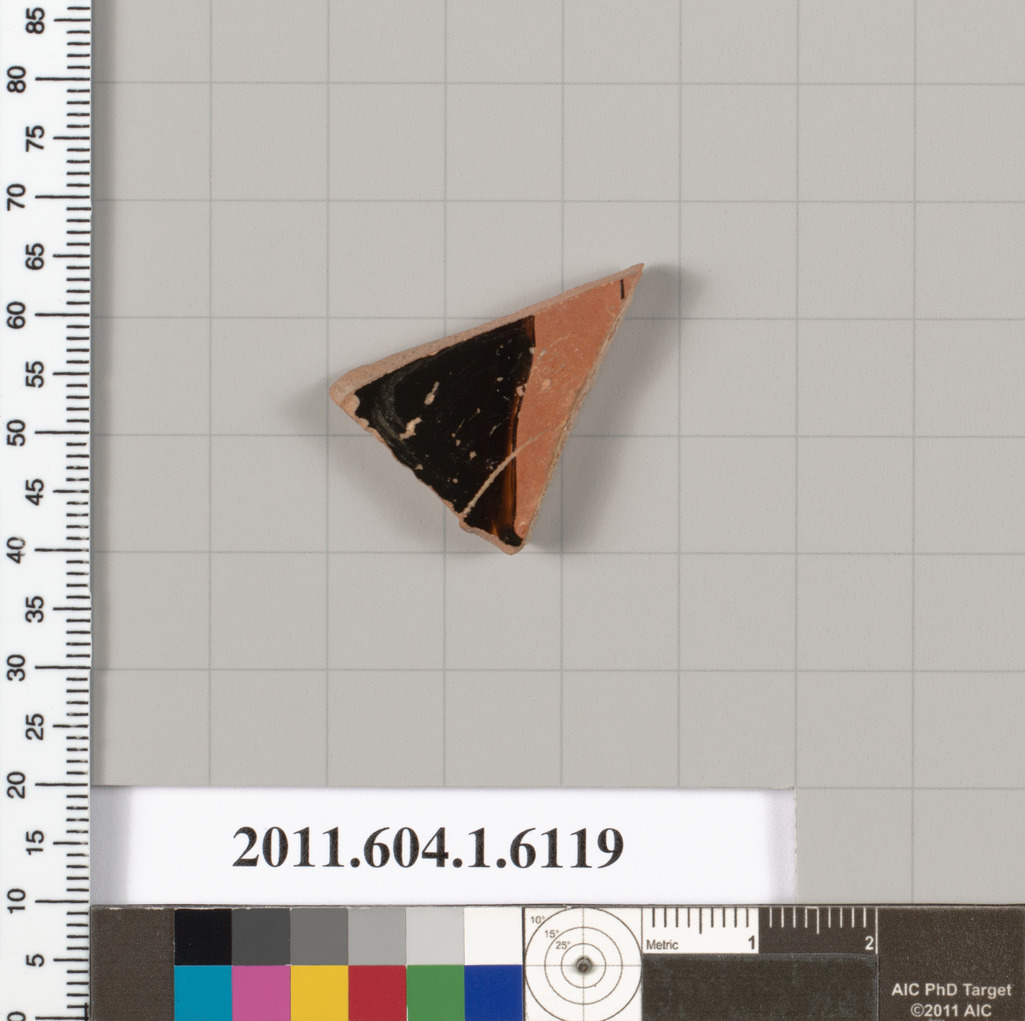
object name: kylix fragment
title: Terracotta fragment of a kylix (drinking cup)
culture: greek, attic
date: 510-490 BCE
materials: terracotta